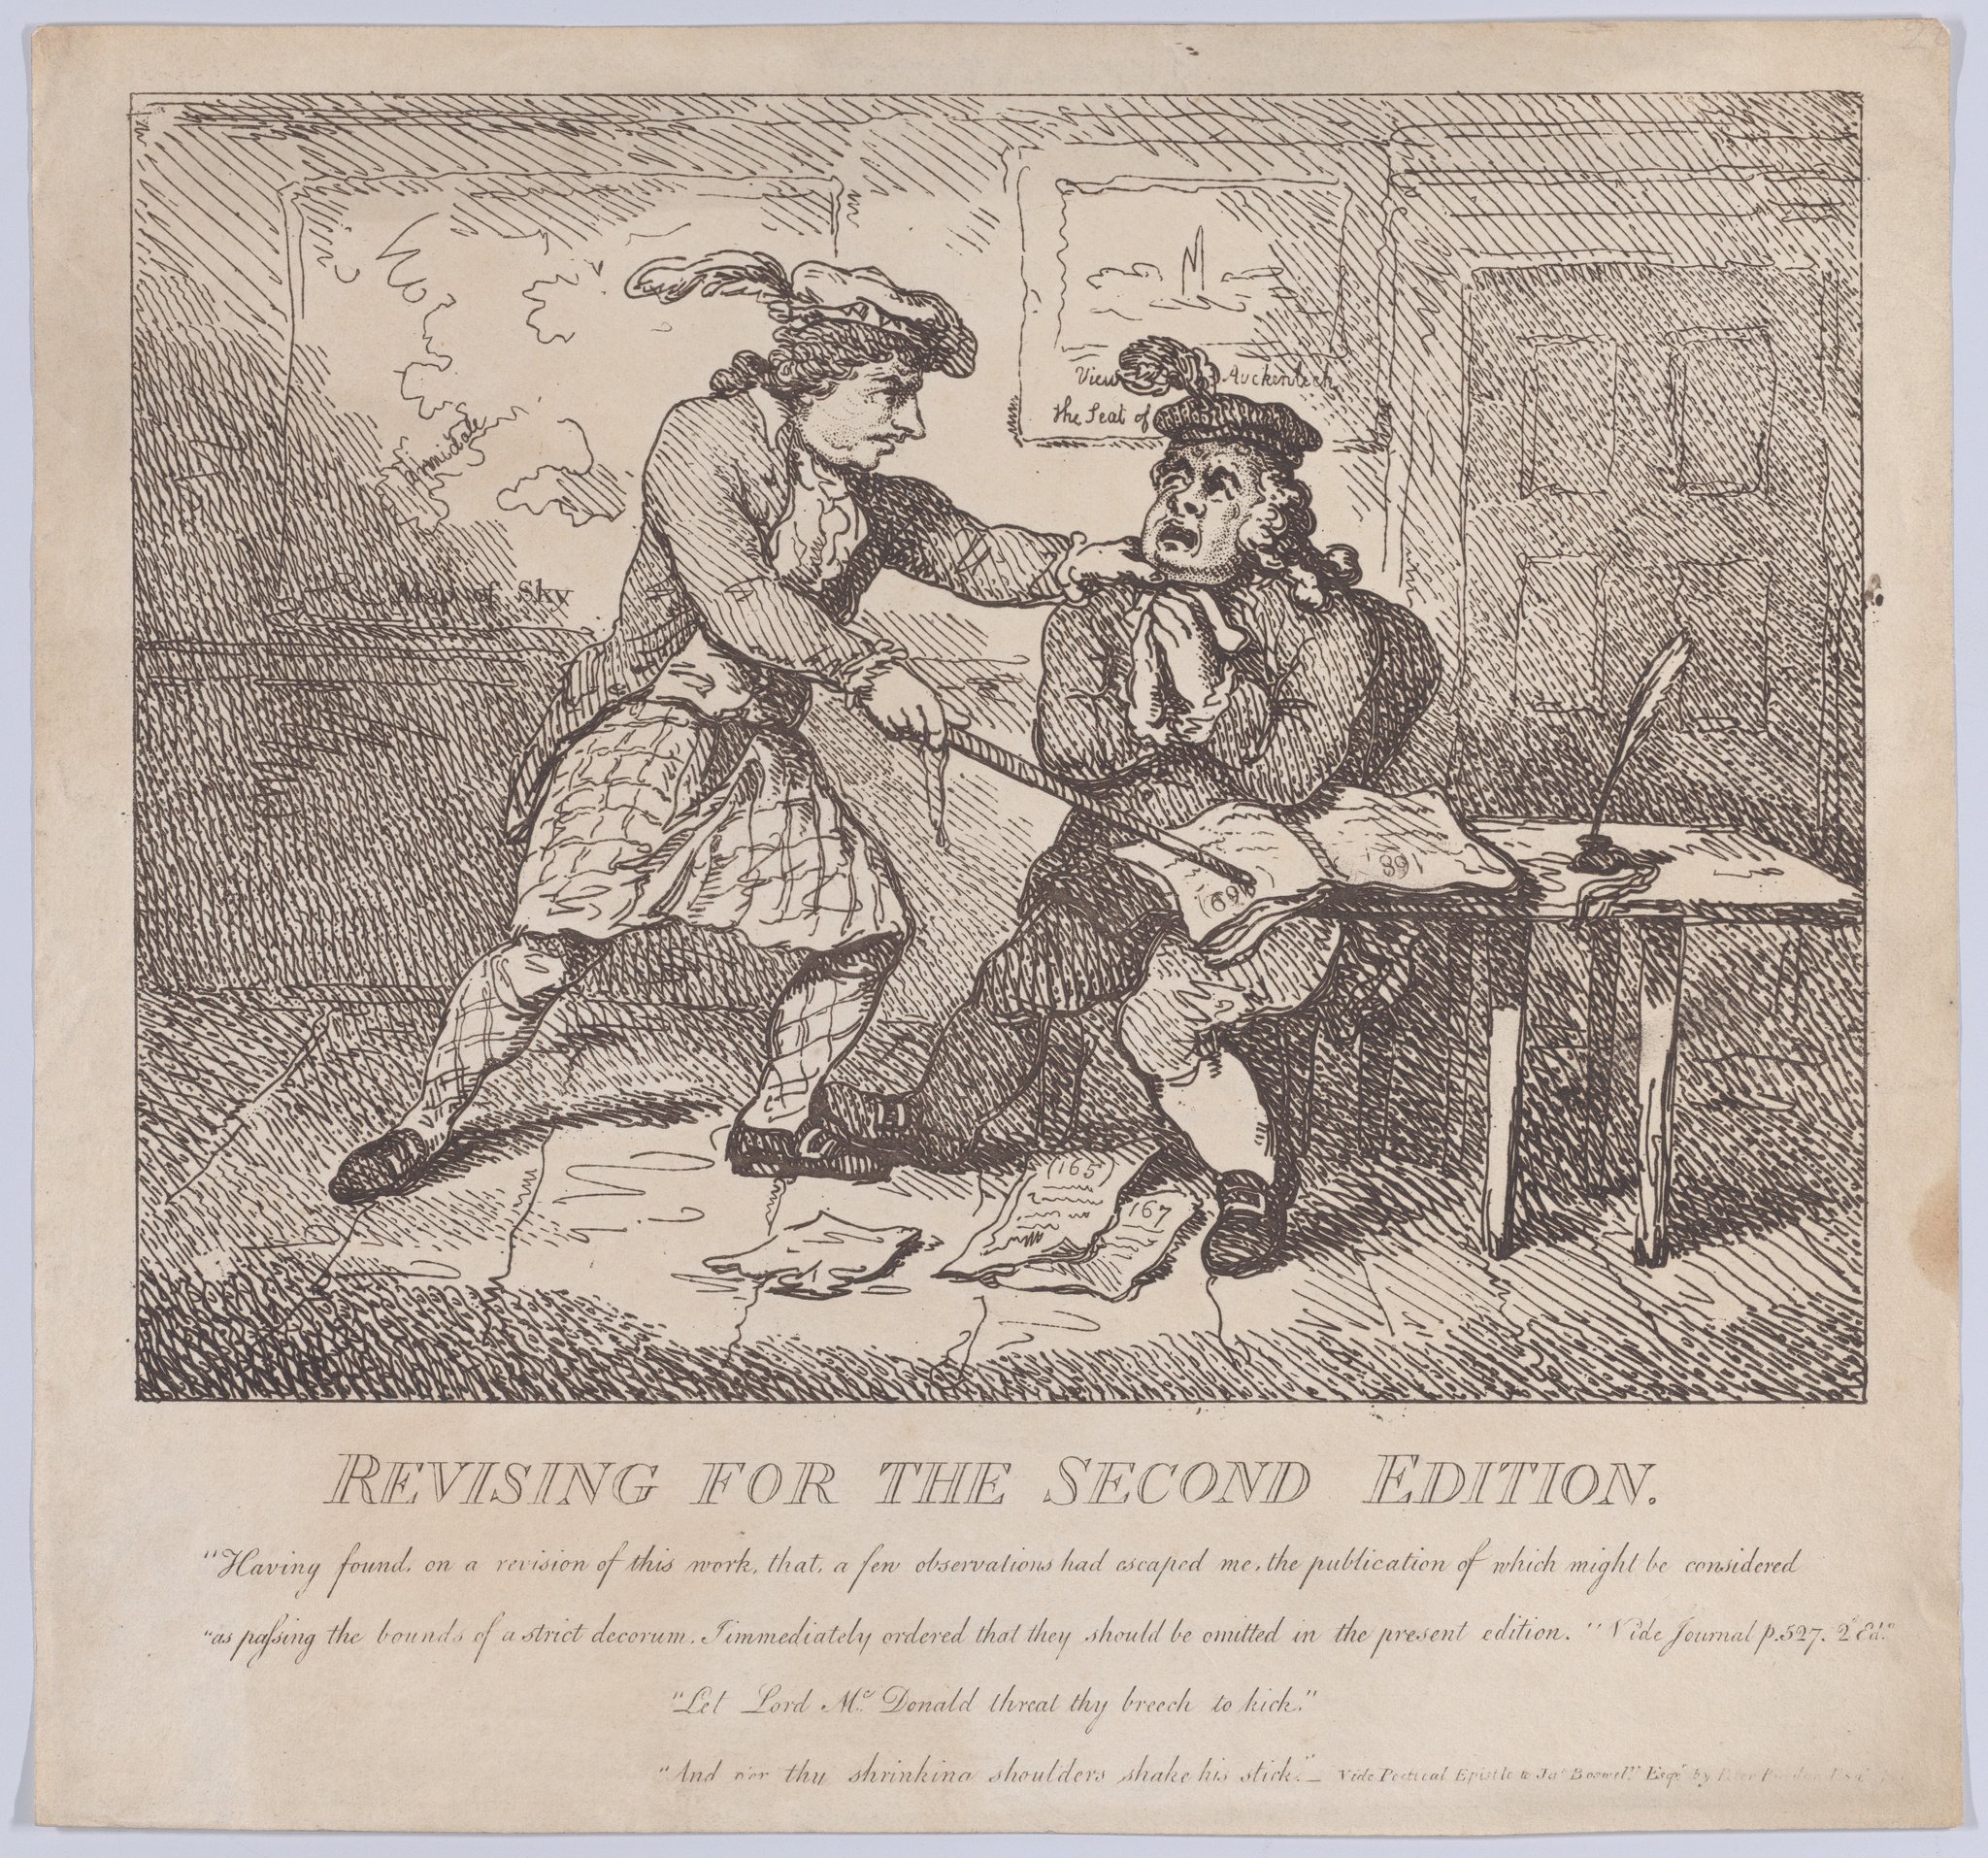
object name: print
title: Frontispiece, Revising for the Second Edition (Picturesque Beauties of Boswell, Part the Second)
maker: thomas rowlandson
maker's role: artist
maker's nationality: british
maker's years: 1757-1827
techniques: etching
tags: satire,men,caricature